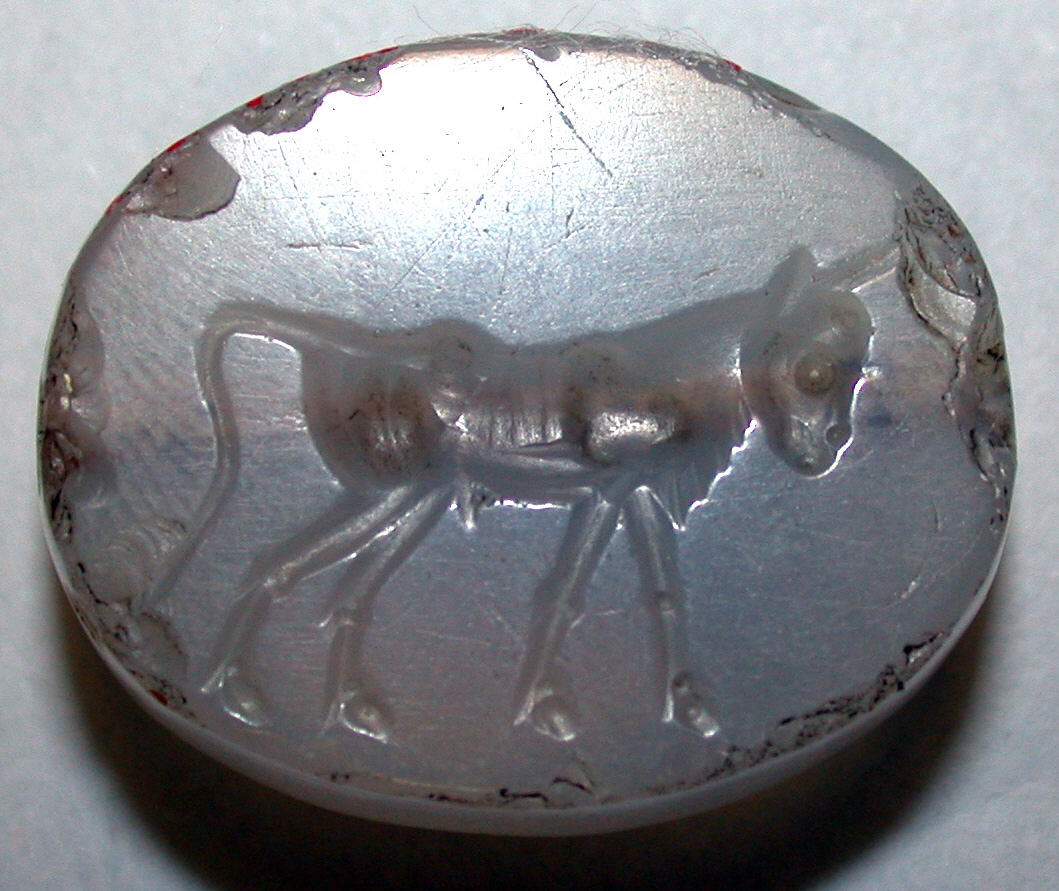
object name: stamp seal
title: Stamp seal (scaraboid) with animal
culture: achaemenid or assyro-babylonian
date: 600-601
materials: stone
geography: mesopotamia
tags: scarabs